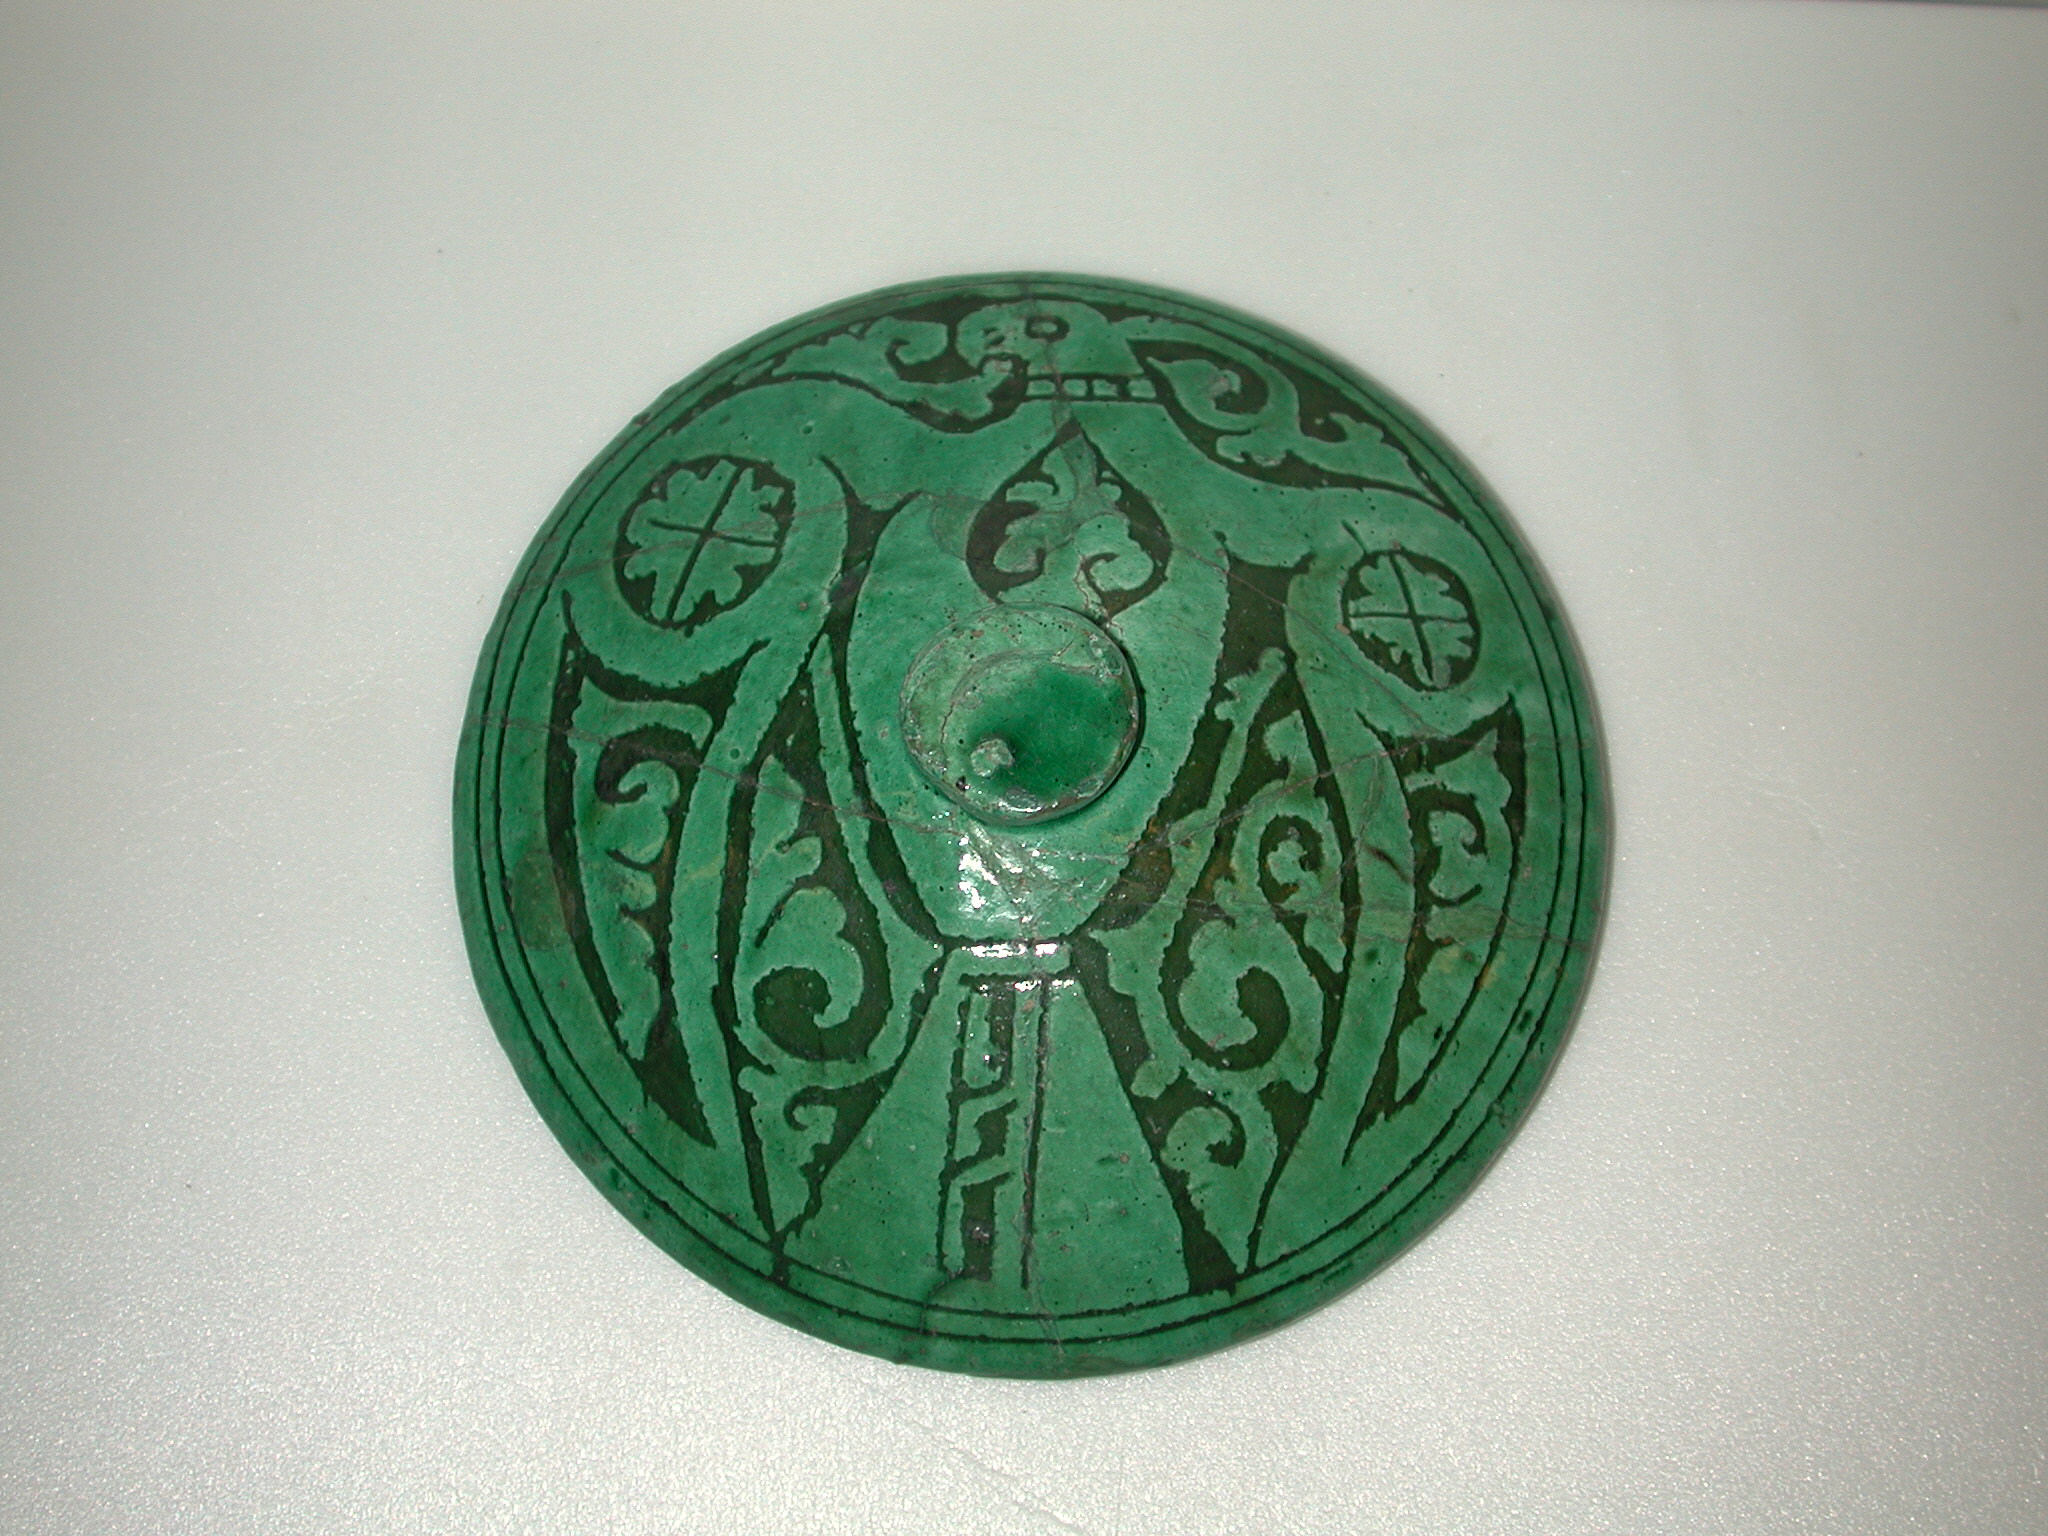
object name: lid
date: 1101-1300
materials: earthenware, glaze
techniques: carving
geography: iran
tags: birds